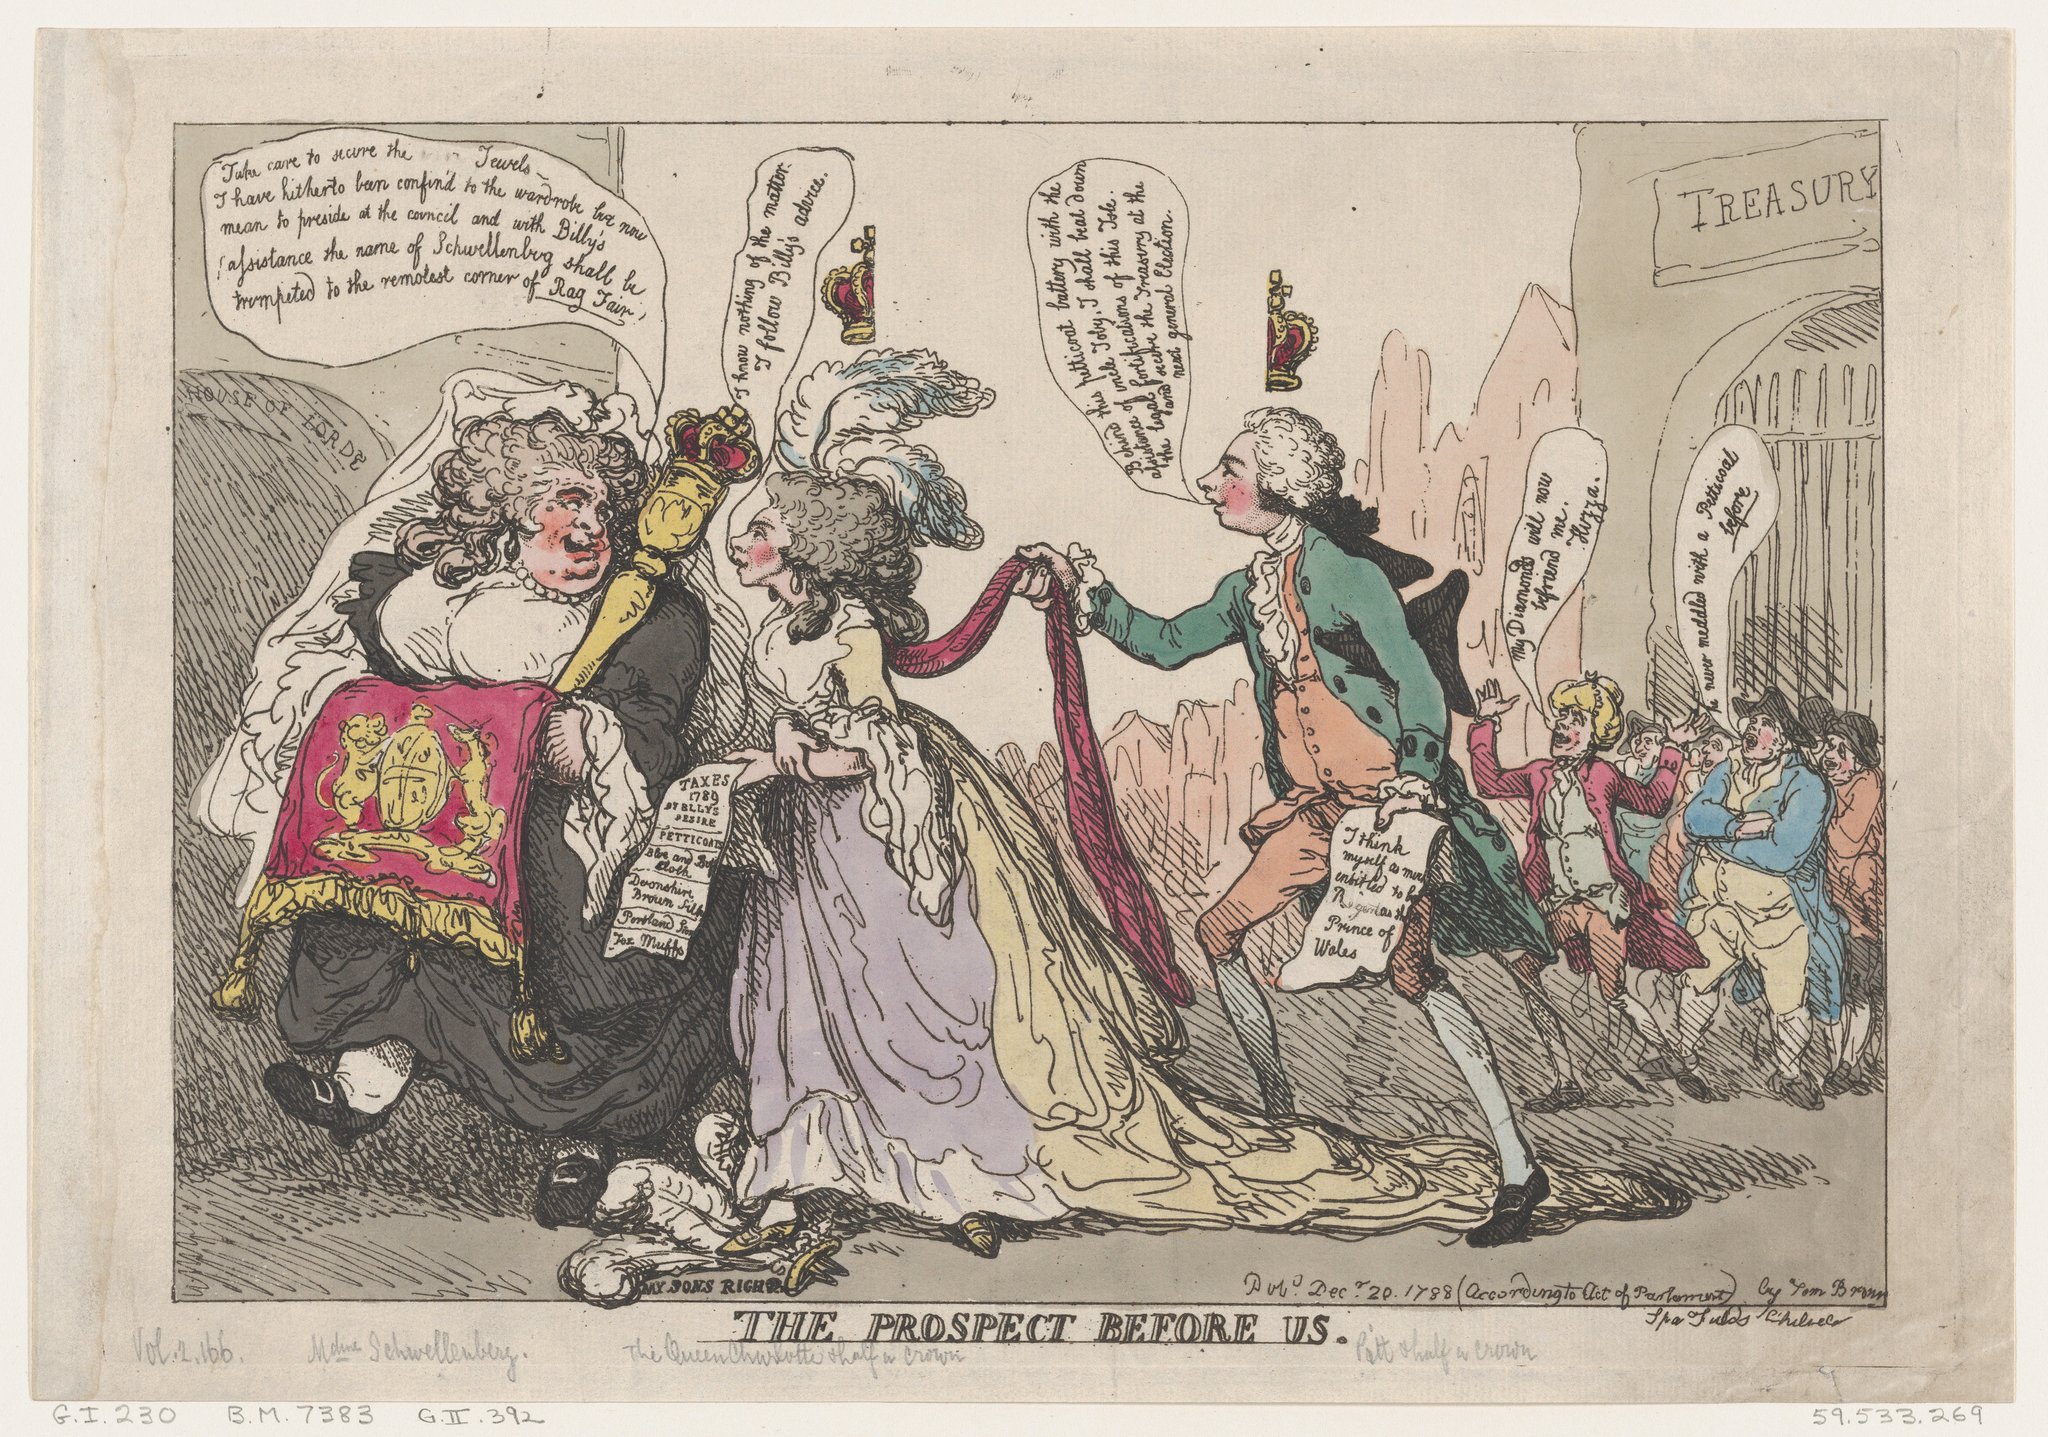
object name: print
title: The Prospect Before Us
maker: thomas rowlandson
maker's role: artist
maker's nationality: british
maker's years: 1757-1827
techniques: etching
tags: satire,men,women